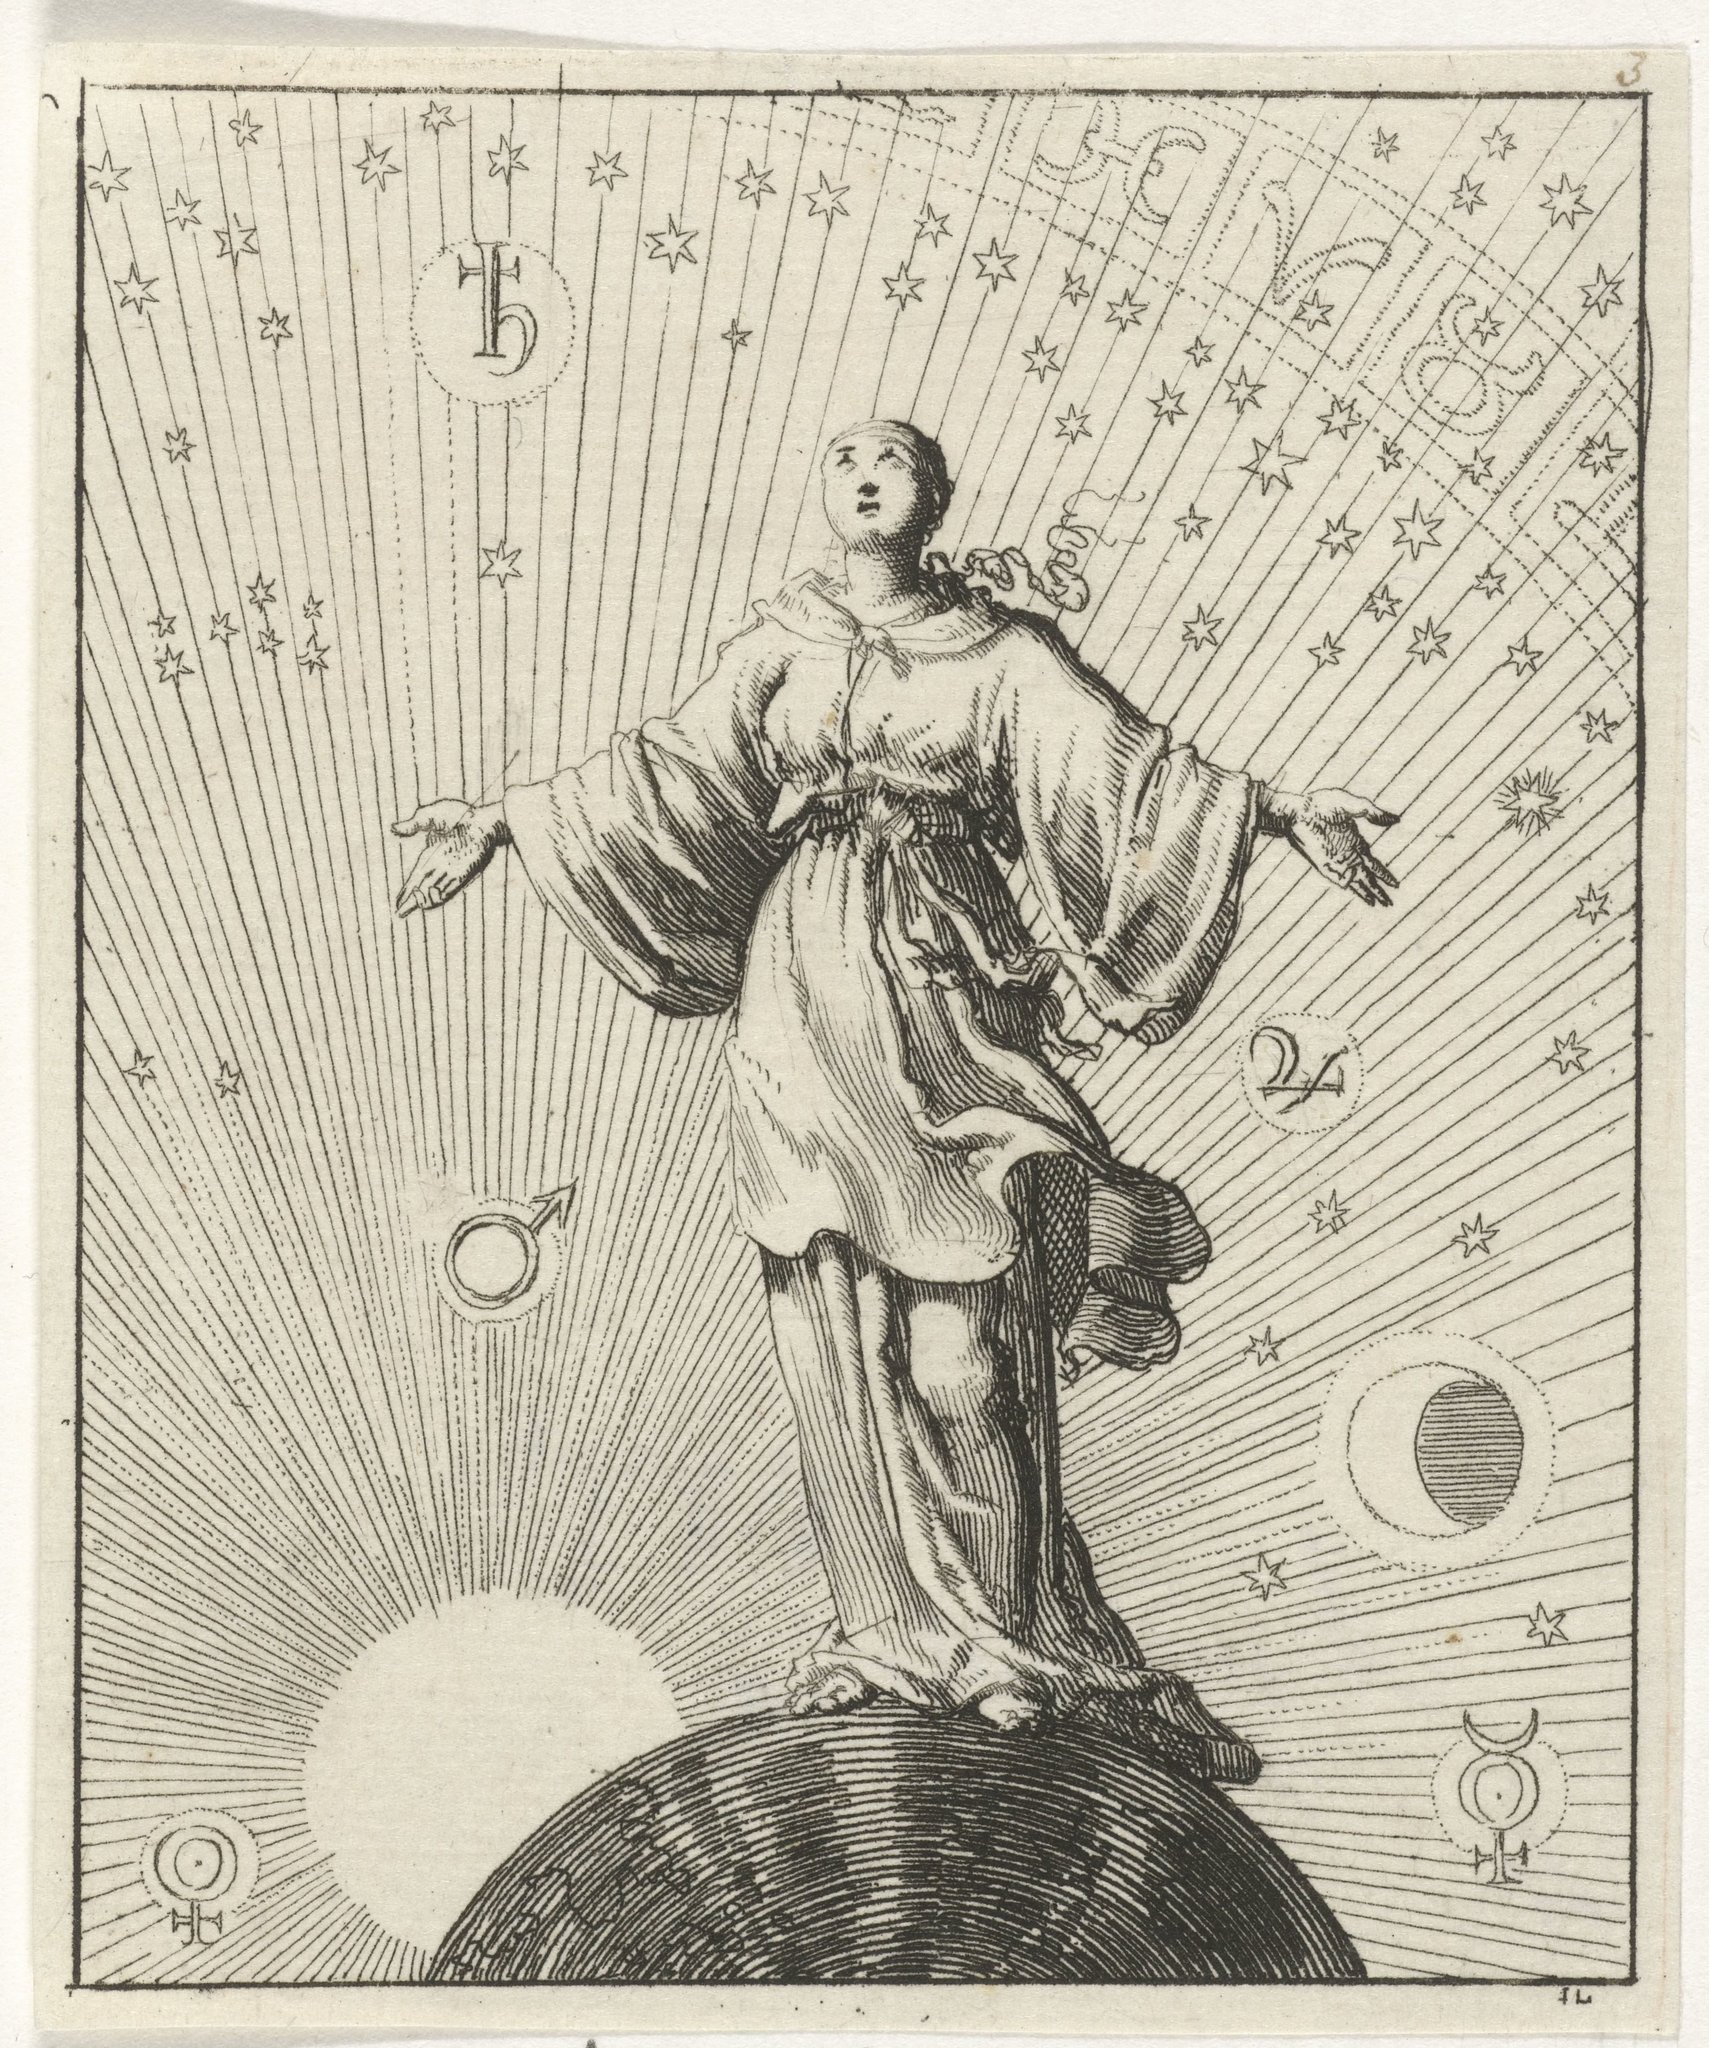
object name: book illustration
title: 't Verborgen goed, Treckt ons gemoed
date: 1687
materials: paper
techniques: etching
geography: amsterdam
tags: globe, stars in the firmament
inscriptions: collector's mark: Lugt 2228, number: ‘3’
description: Illustratie uit: Luyken, Jan. Voncken der liefde Jesu, van het godtbegerende zielenvier. Amsterdam: Pieter Arentsz (II), 1687, p. 10.